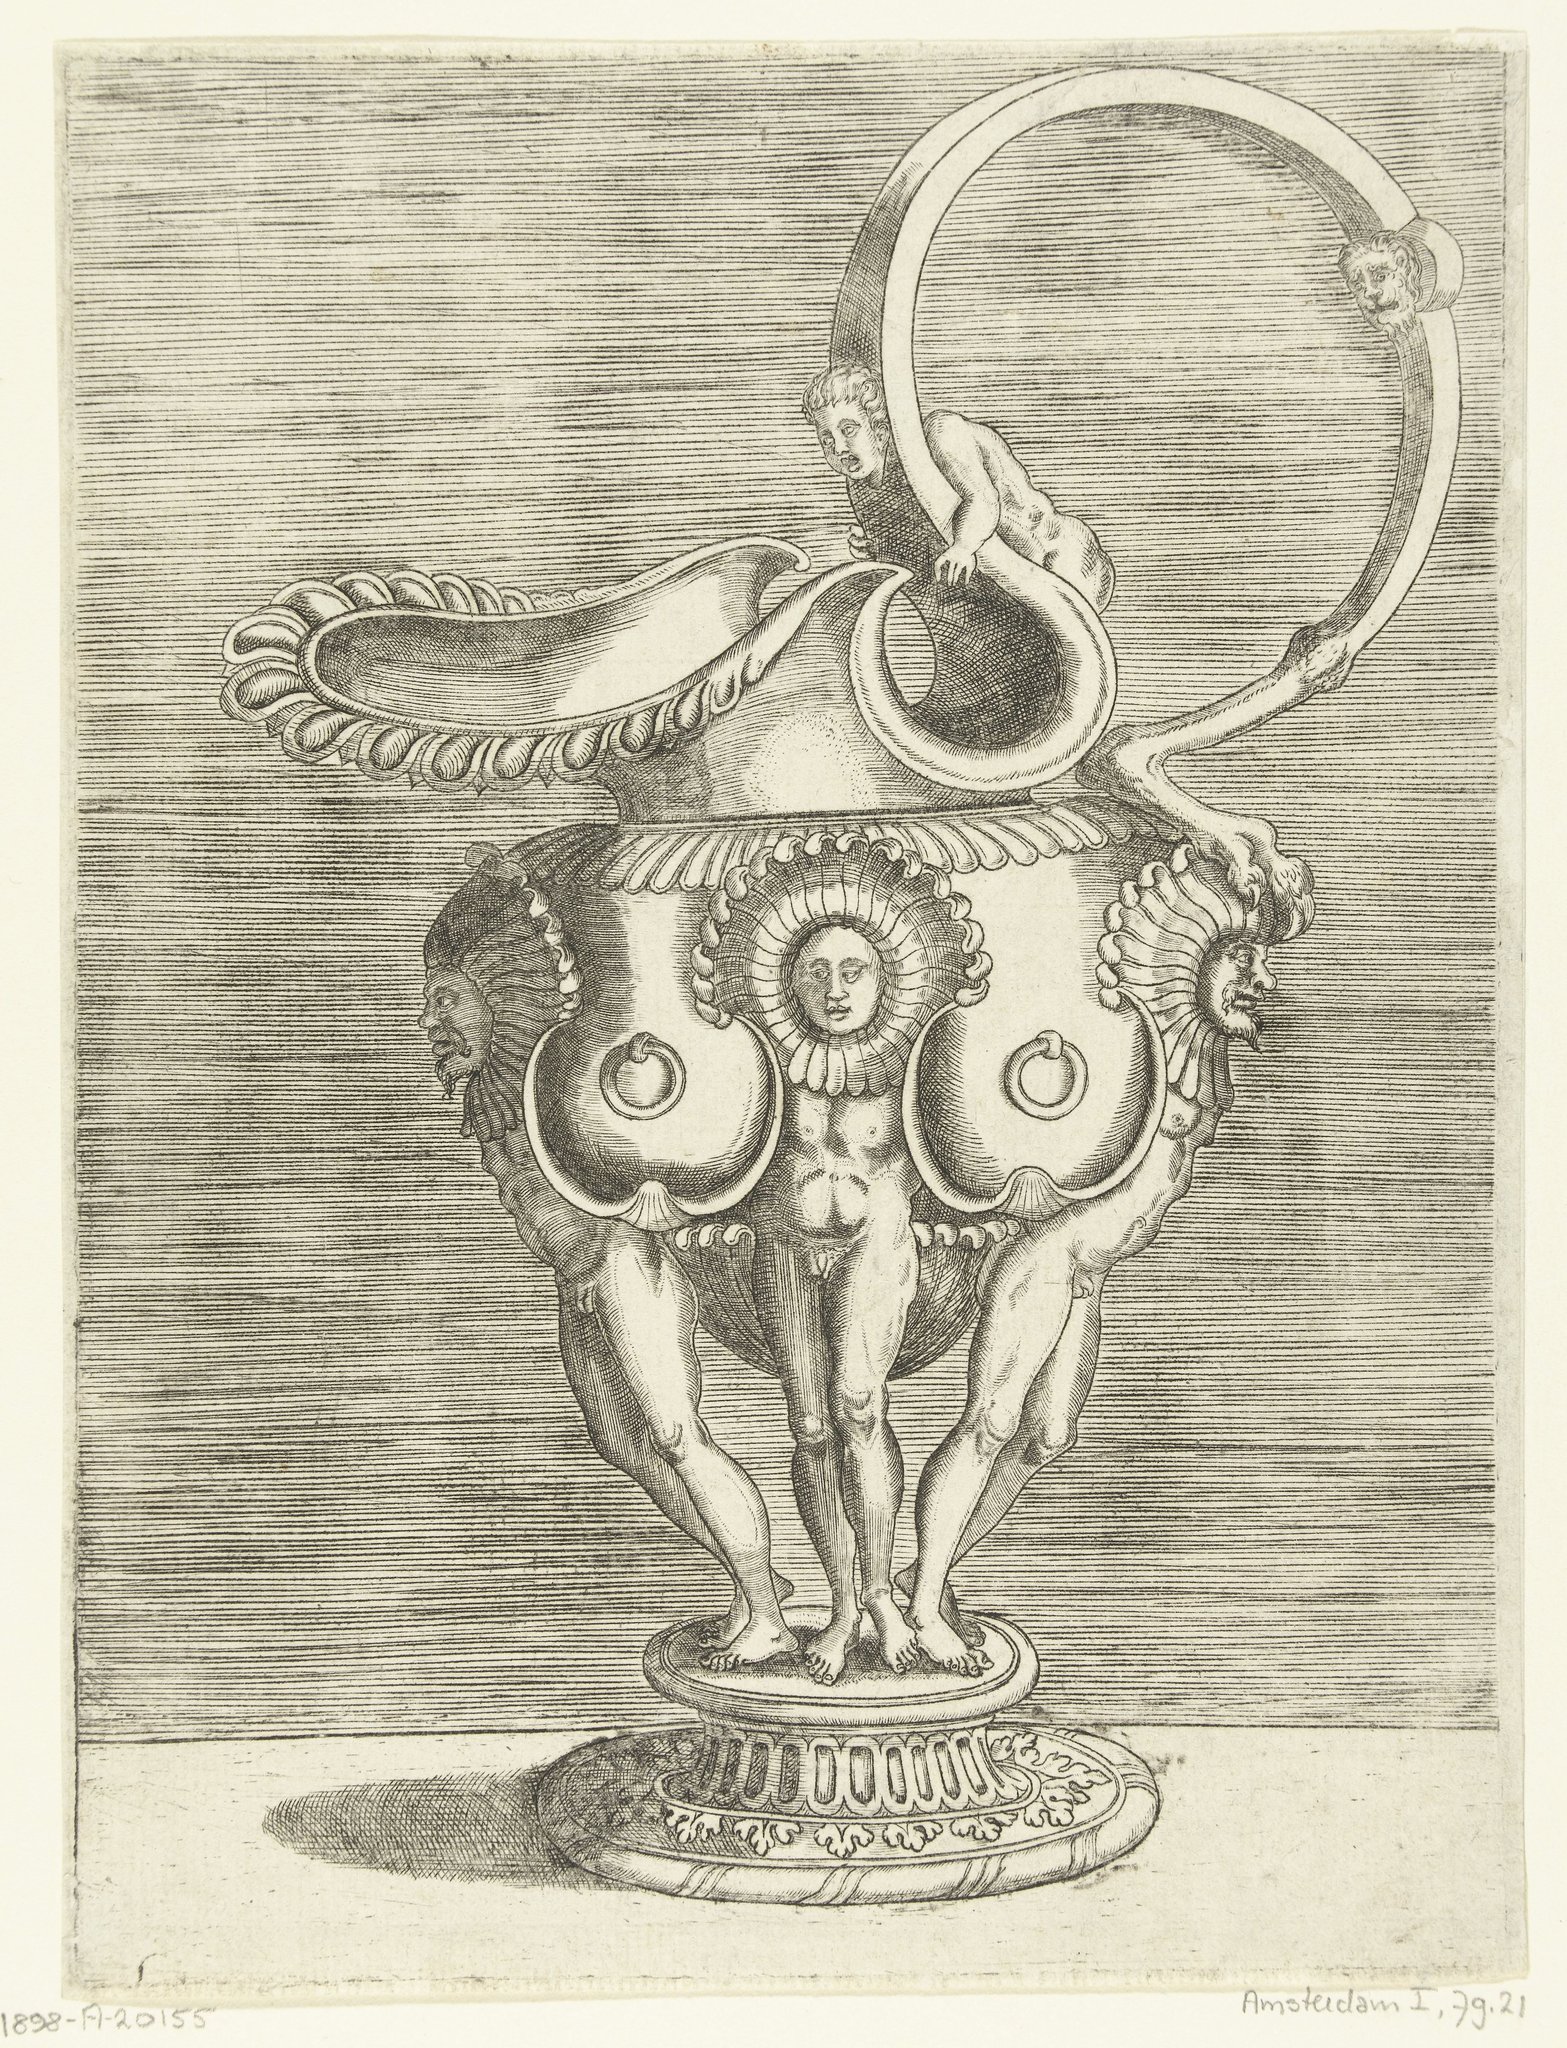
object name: print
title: Kan met oor, gedragen door drie figuren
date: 1548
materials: paper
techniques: engraving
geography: netherlands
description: De kan wordt gedragen door drie figuren die met hun hoofden door een op de buik van de kan vastzittende kraag kijken. Door het oor hangt een kind. Afkomstig uit een serie bestaande uit een titelblad en 20 bladen.